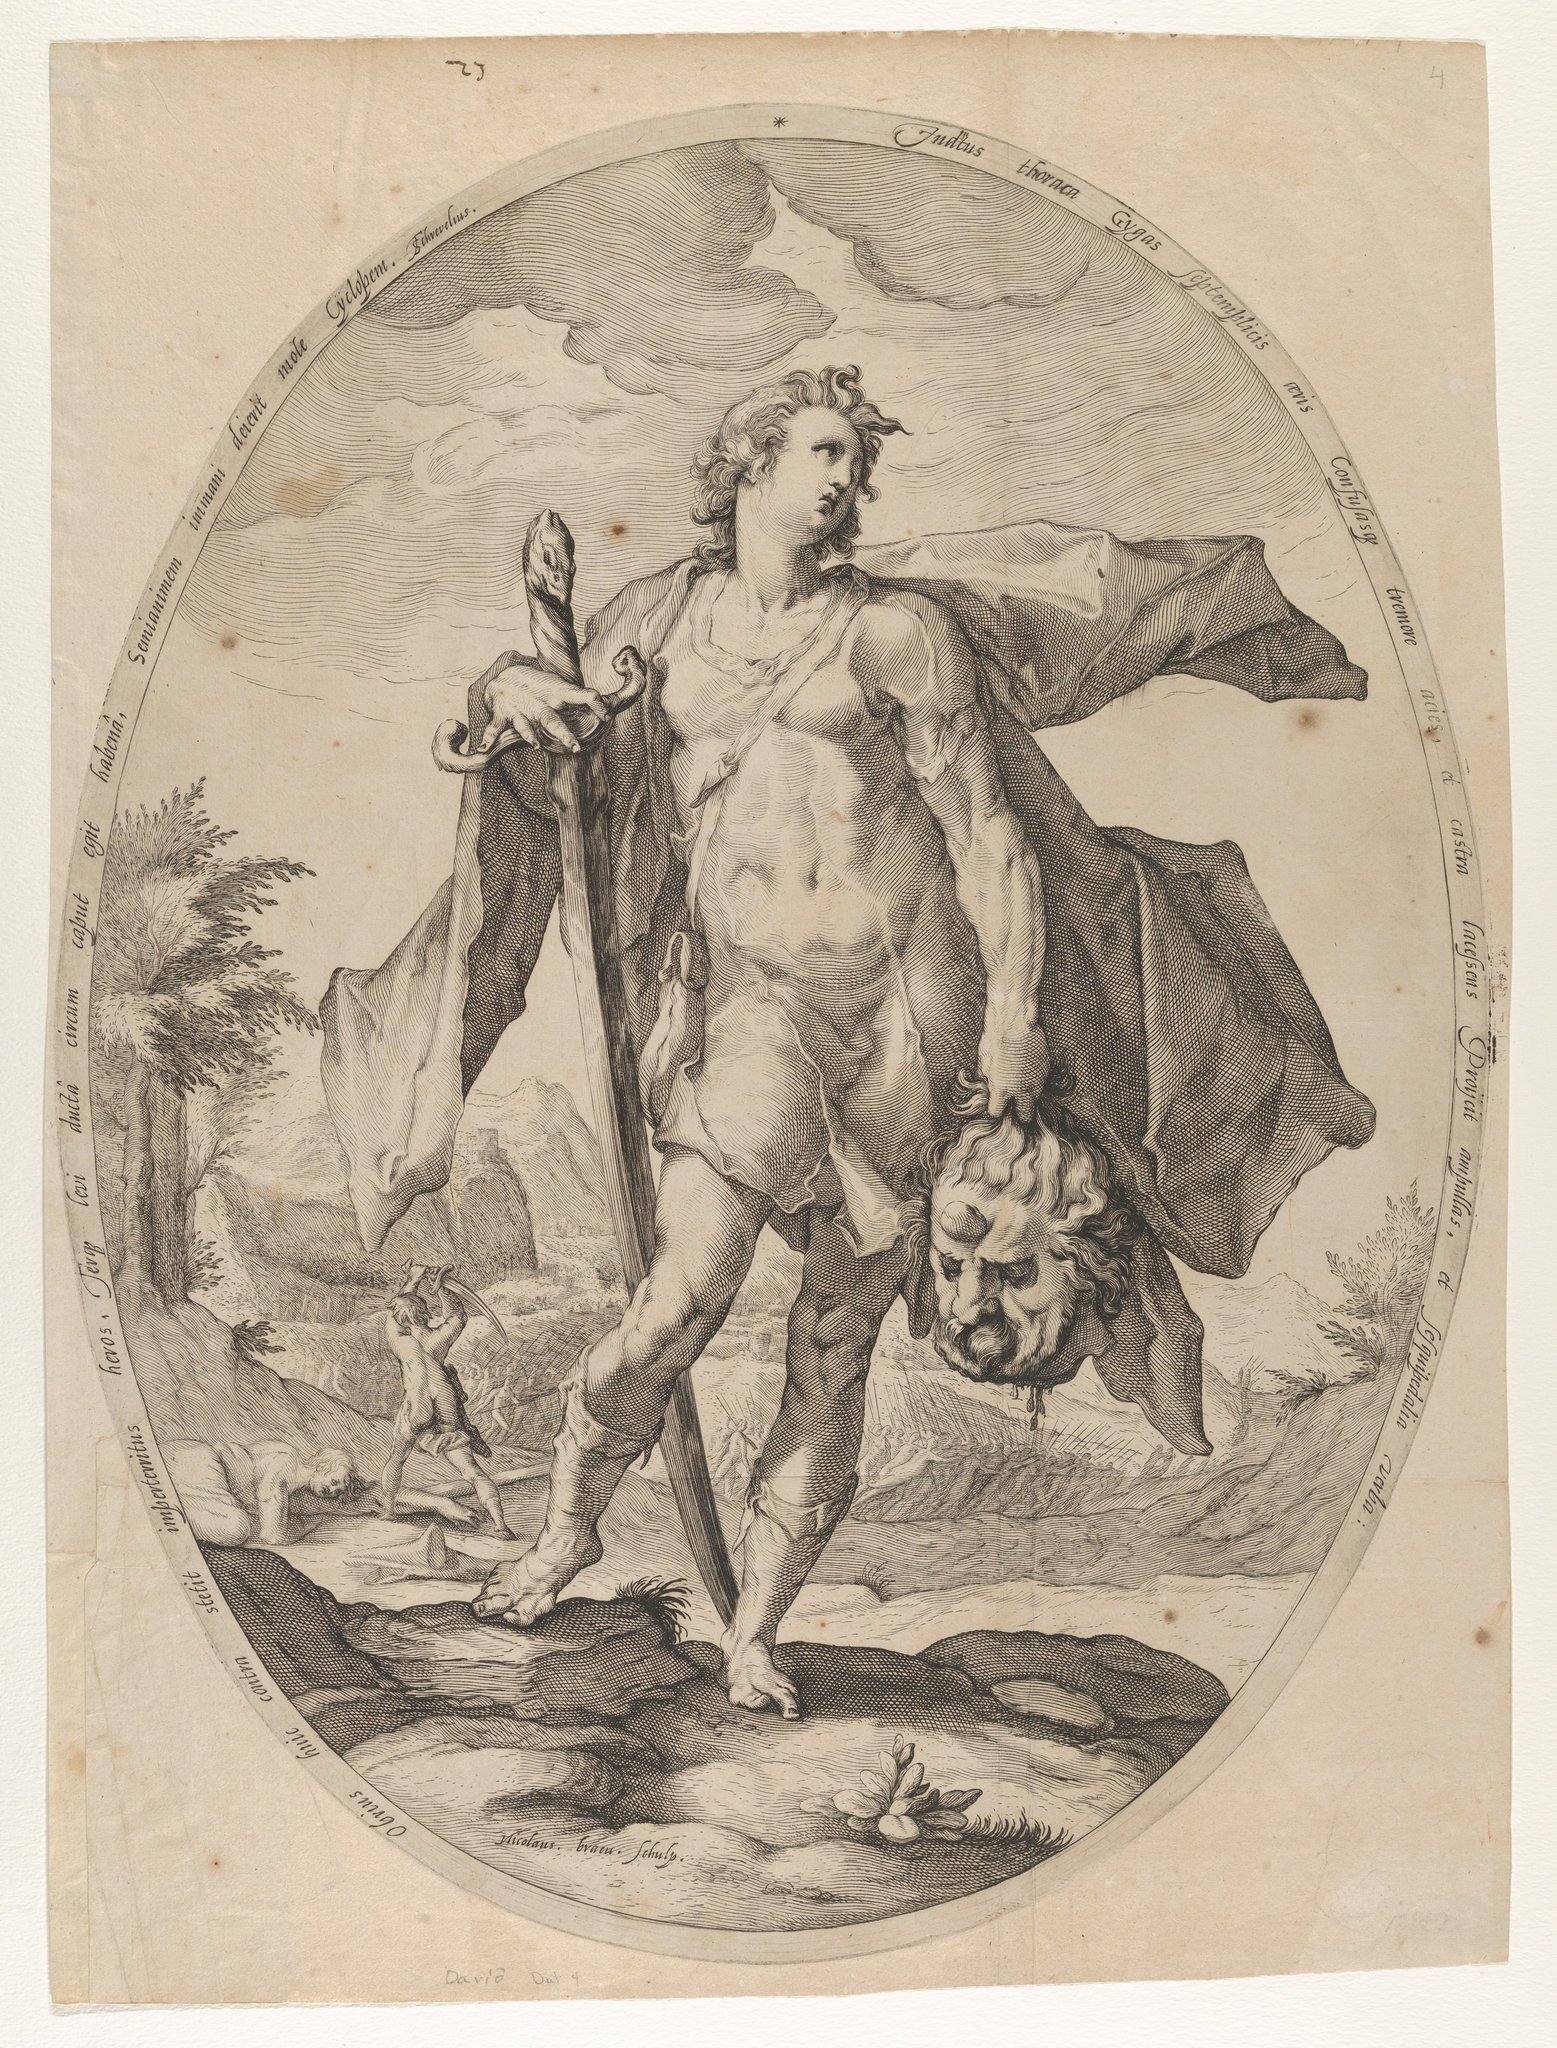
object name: print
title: David, from "Heroes and Heroines of the Old Testament"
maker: nicolaes braeu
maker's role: artist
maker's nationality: netherlandish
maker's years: 1586-1600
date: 1597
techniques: engraving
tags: swords,heads,david